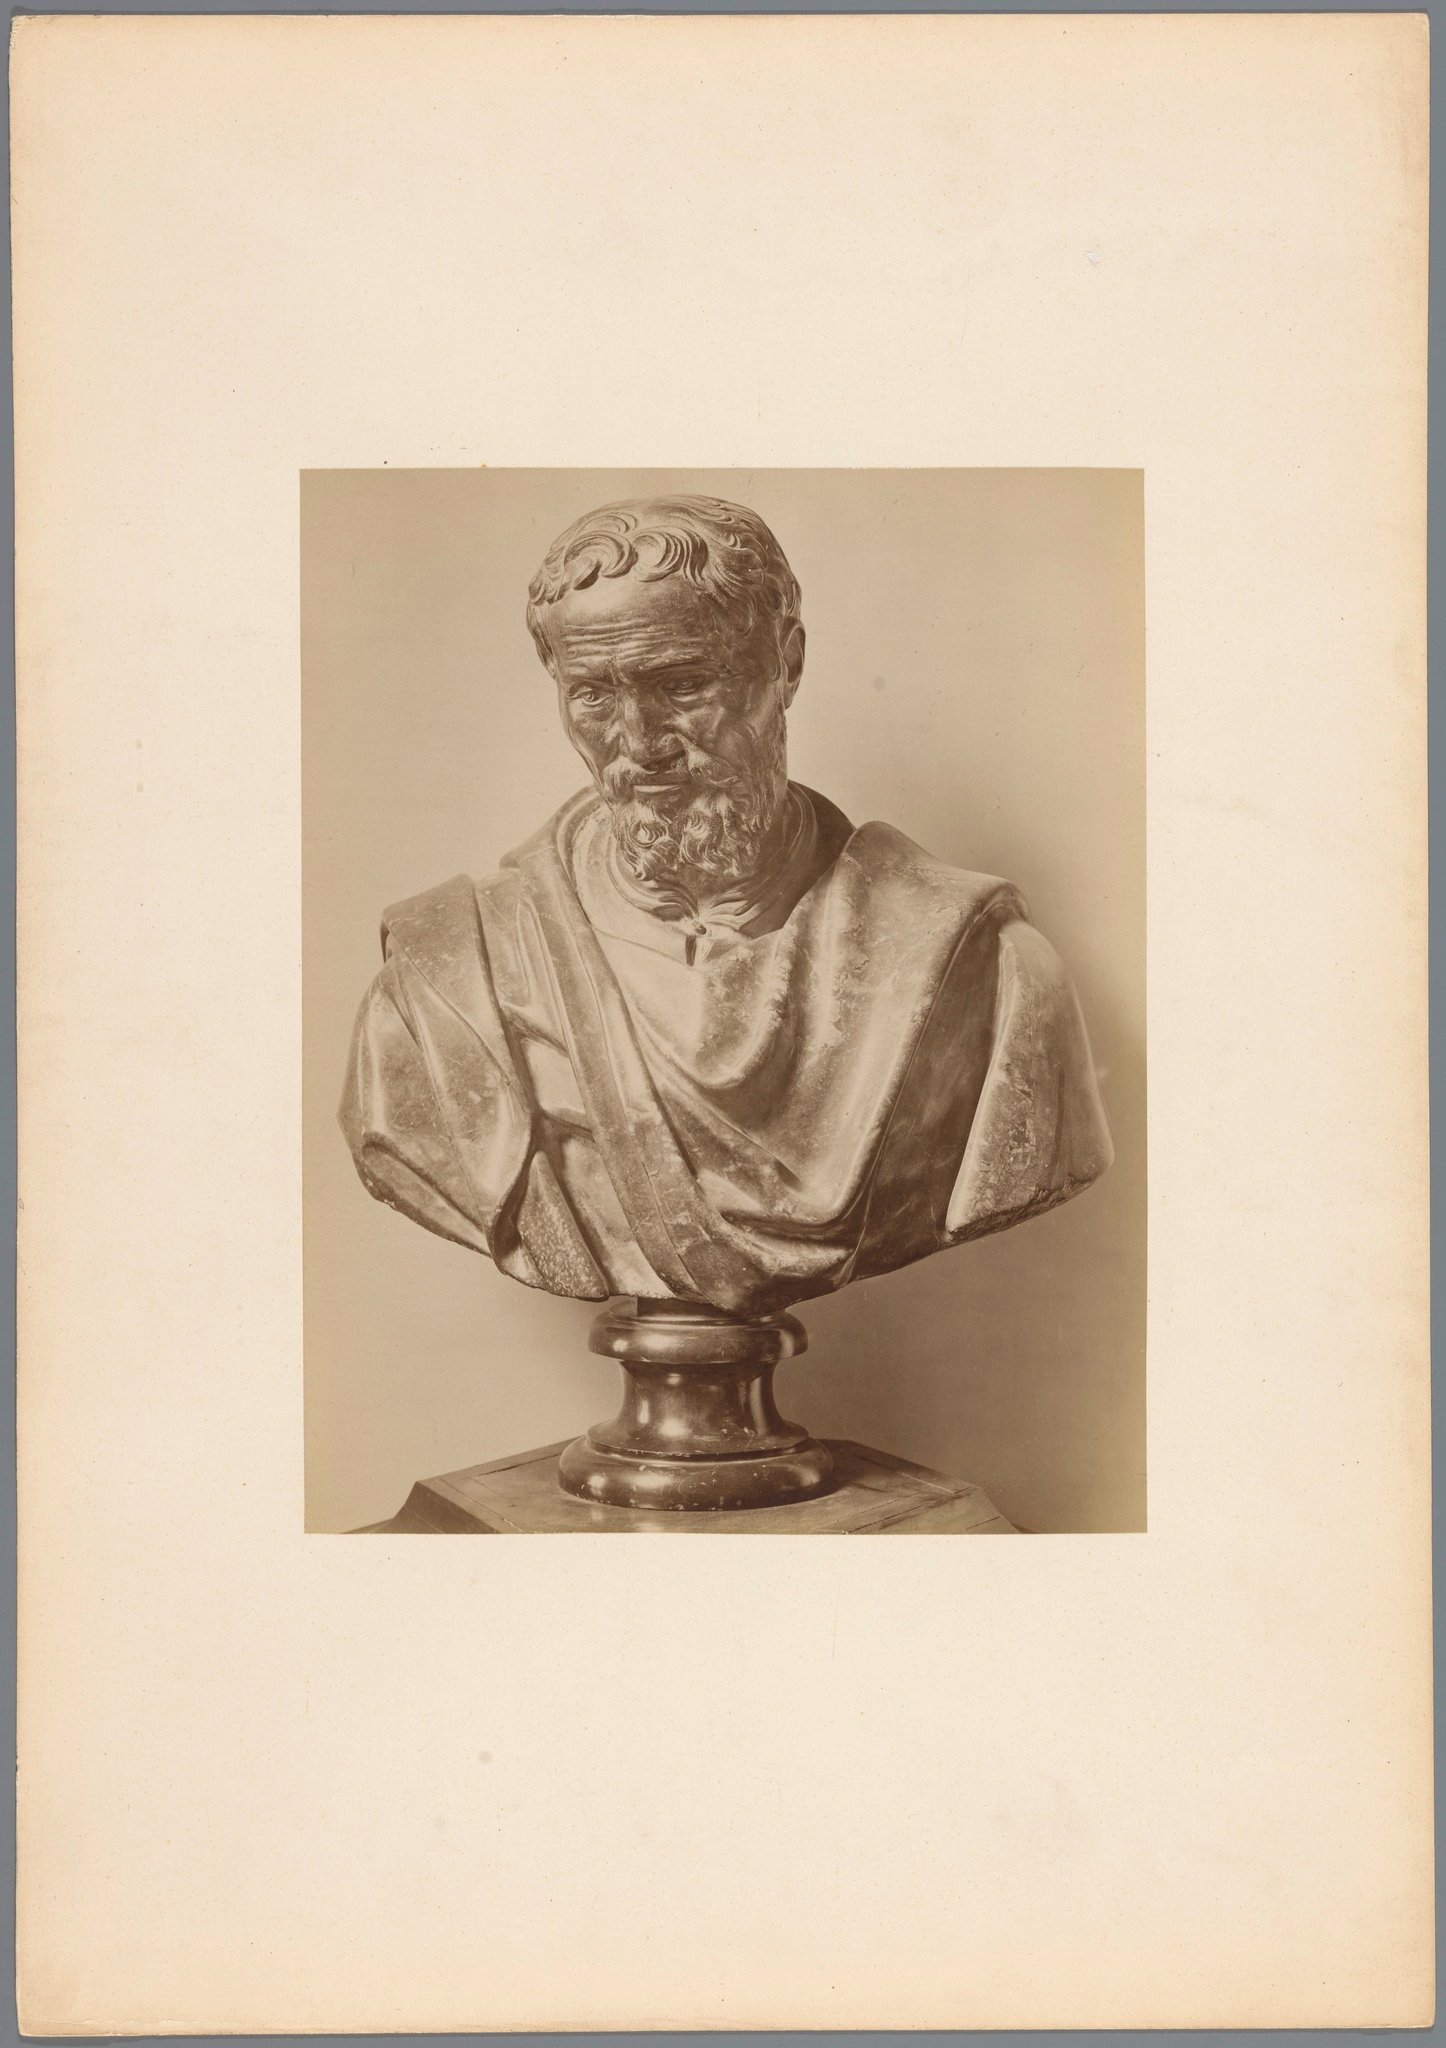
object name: photograph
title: Buste van een man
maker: Anonymous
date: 1875-1900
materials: cardboard, photographic support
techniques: albumen print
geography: europe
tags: chest, bust, europe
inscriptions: collector's mark: ‘INSTITUUT VOOR KUNST-NIJVERHEIDSONDERWIJS GABRIËL METSUSTRAAT No. 16 AMSTERDAM’, collector's mark: ‘KUNSTNIJVERHEIDSCHOOL QUELLINUS AMSTERDAM FRANS HALSSTRAAT 14.’